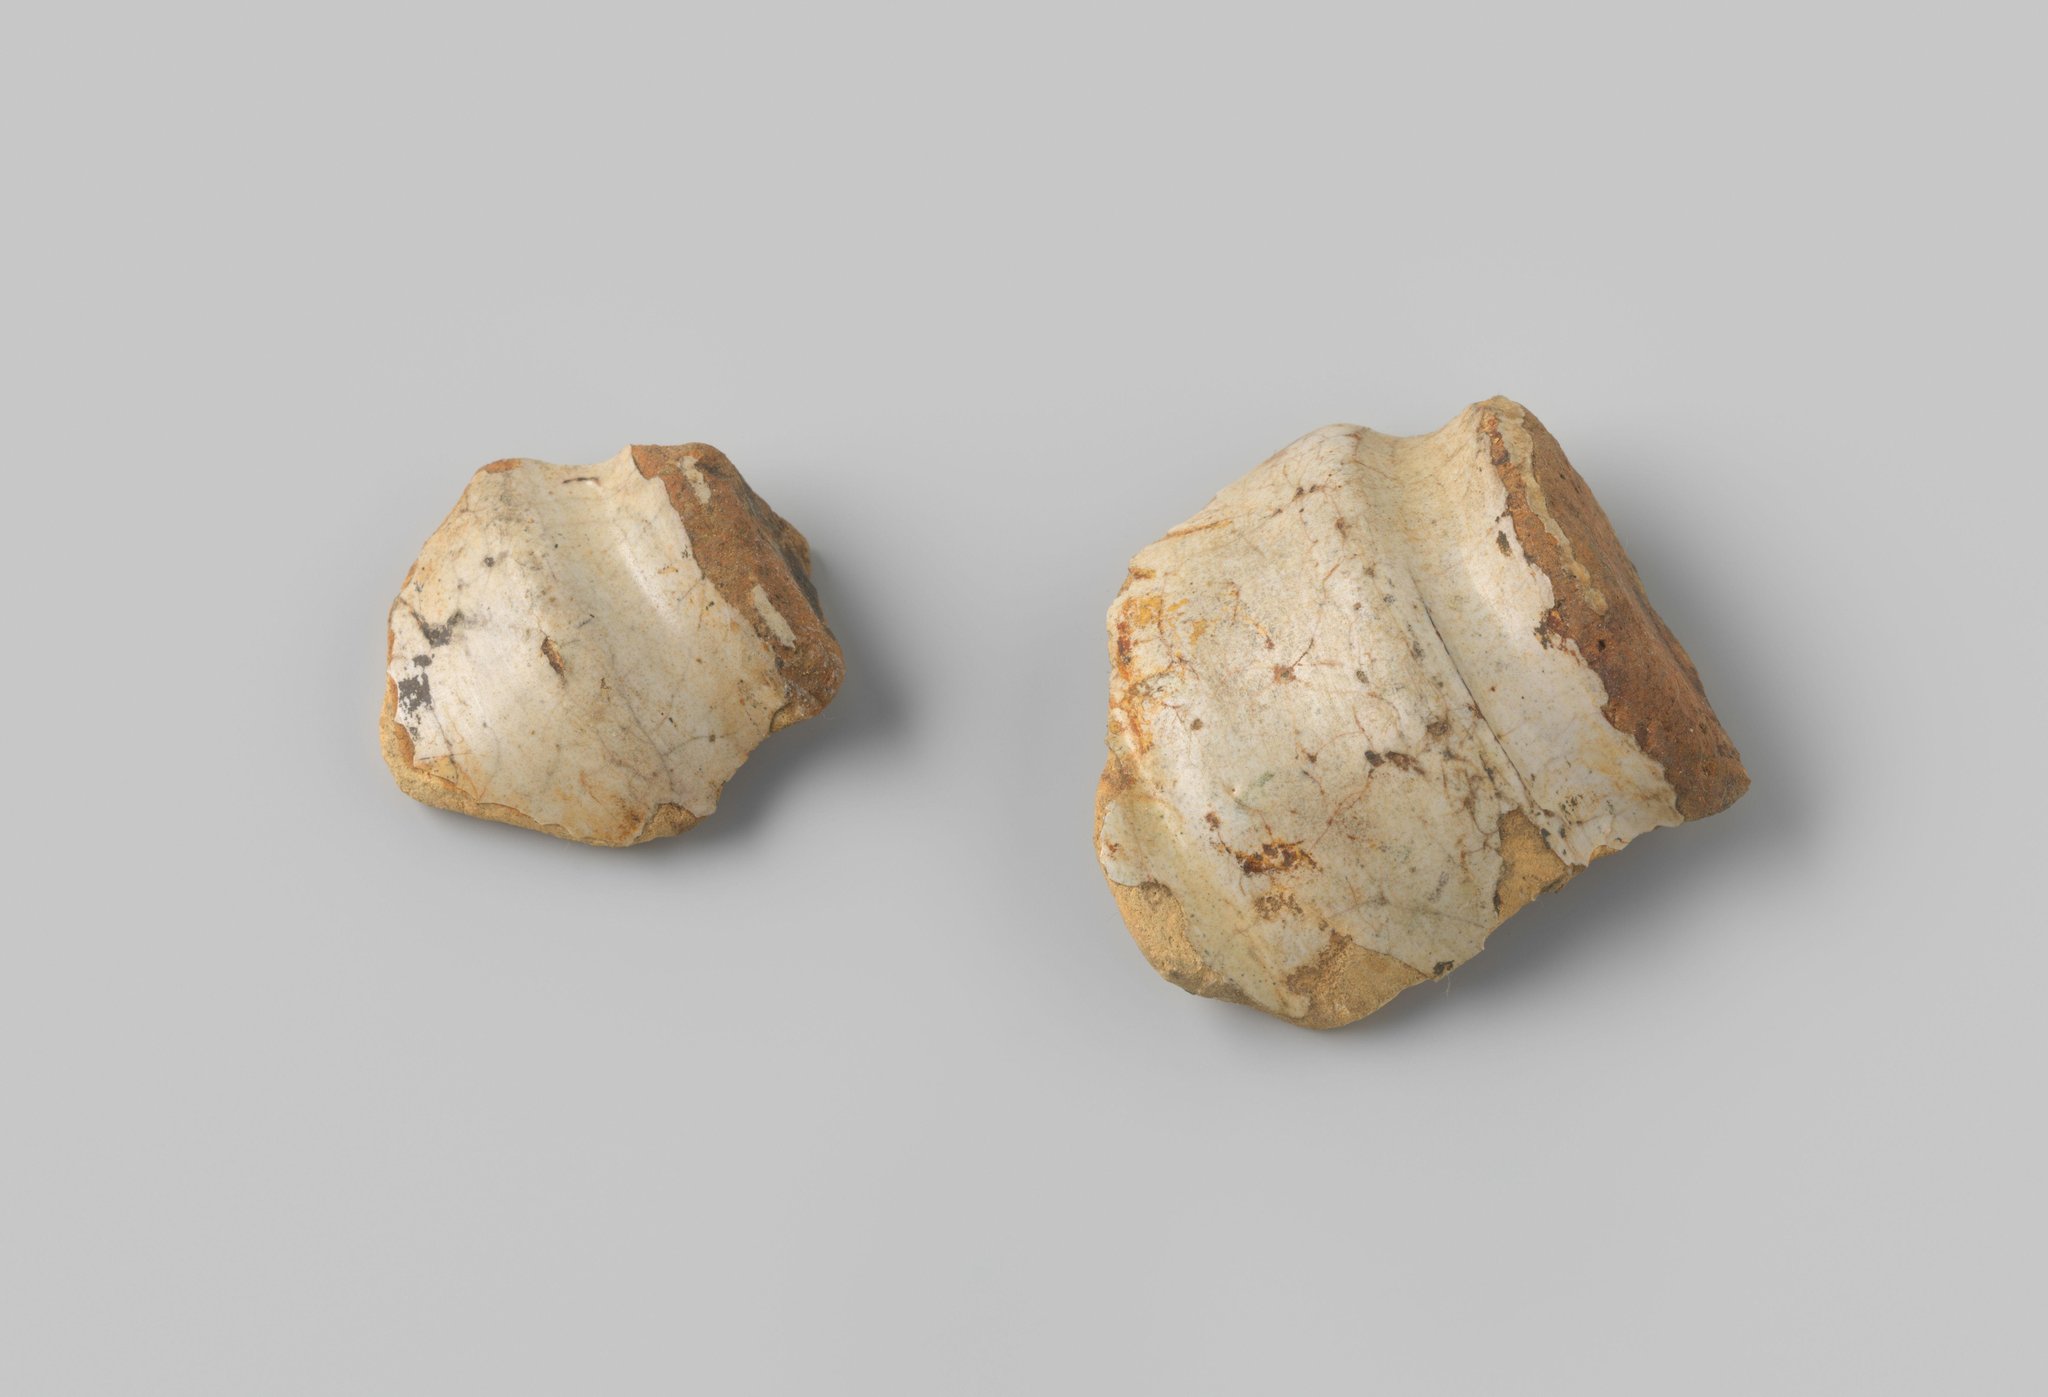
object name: sherd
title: Scherven van apothekerspotten uit het wrak van de Oost-Indiëvaarder Hollandia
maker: Anonymous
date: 1700-1743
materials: faience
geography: netherlands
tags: verenigde oostindische compagnie, hollandia (schip), annet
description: Faience (tin-glazed), apothecaries'jars; fragm of rim and base, eroded, circular, straight, slightly tapering body, semicircular notch under rim and above base, underside of base not glazed.